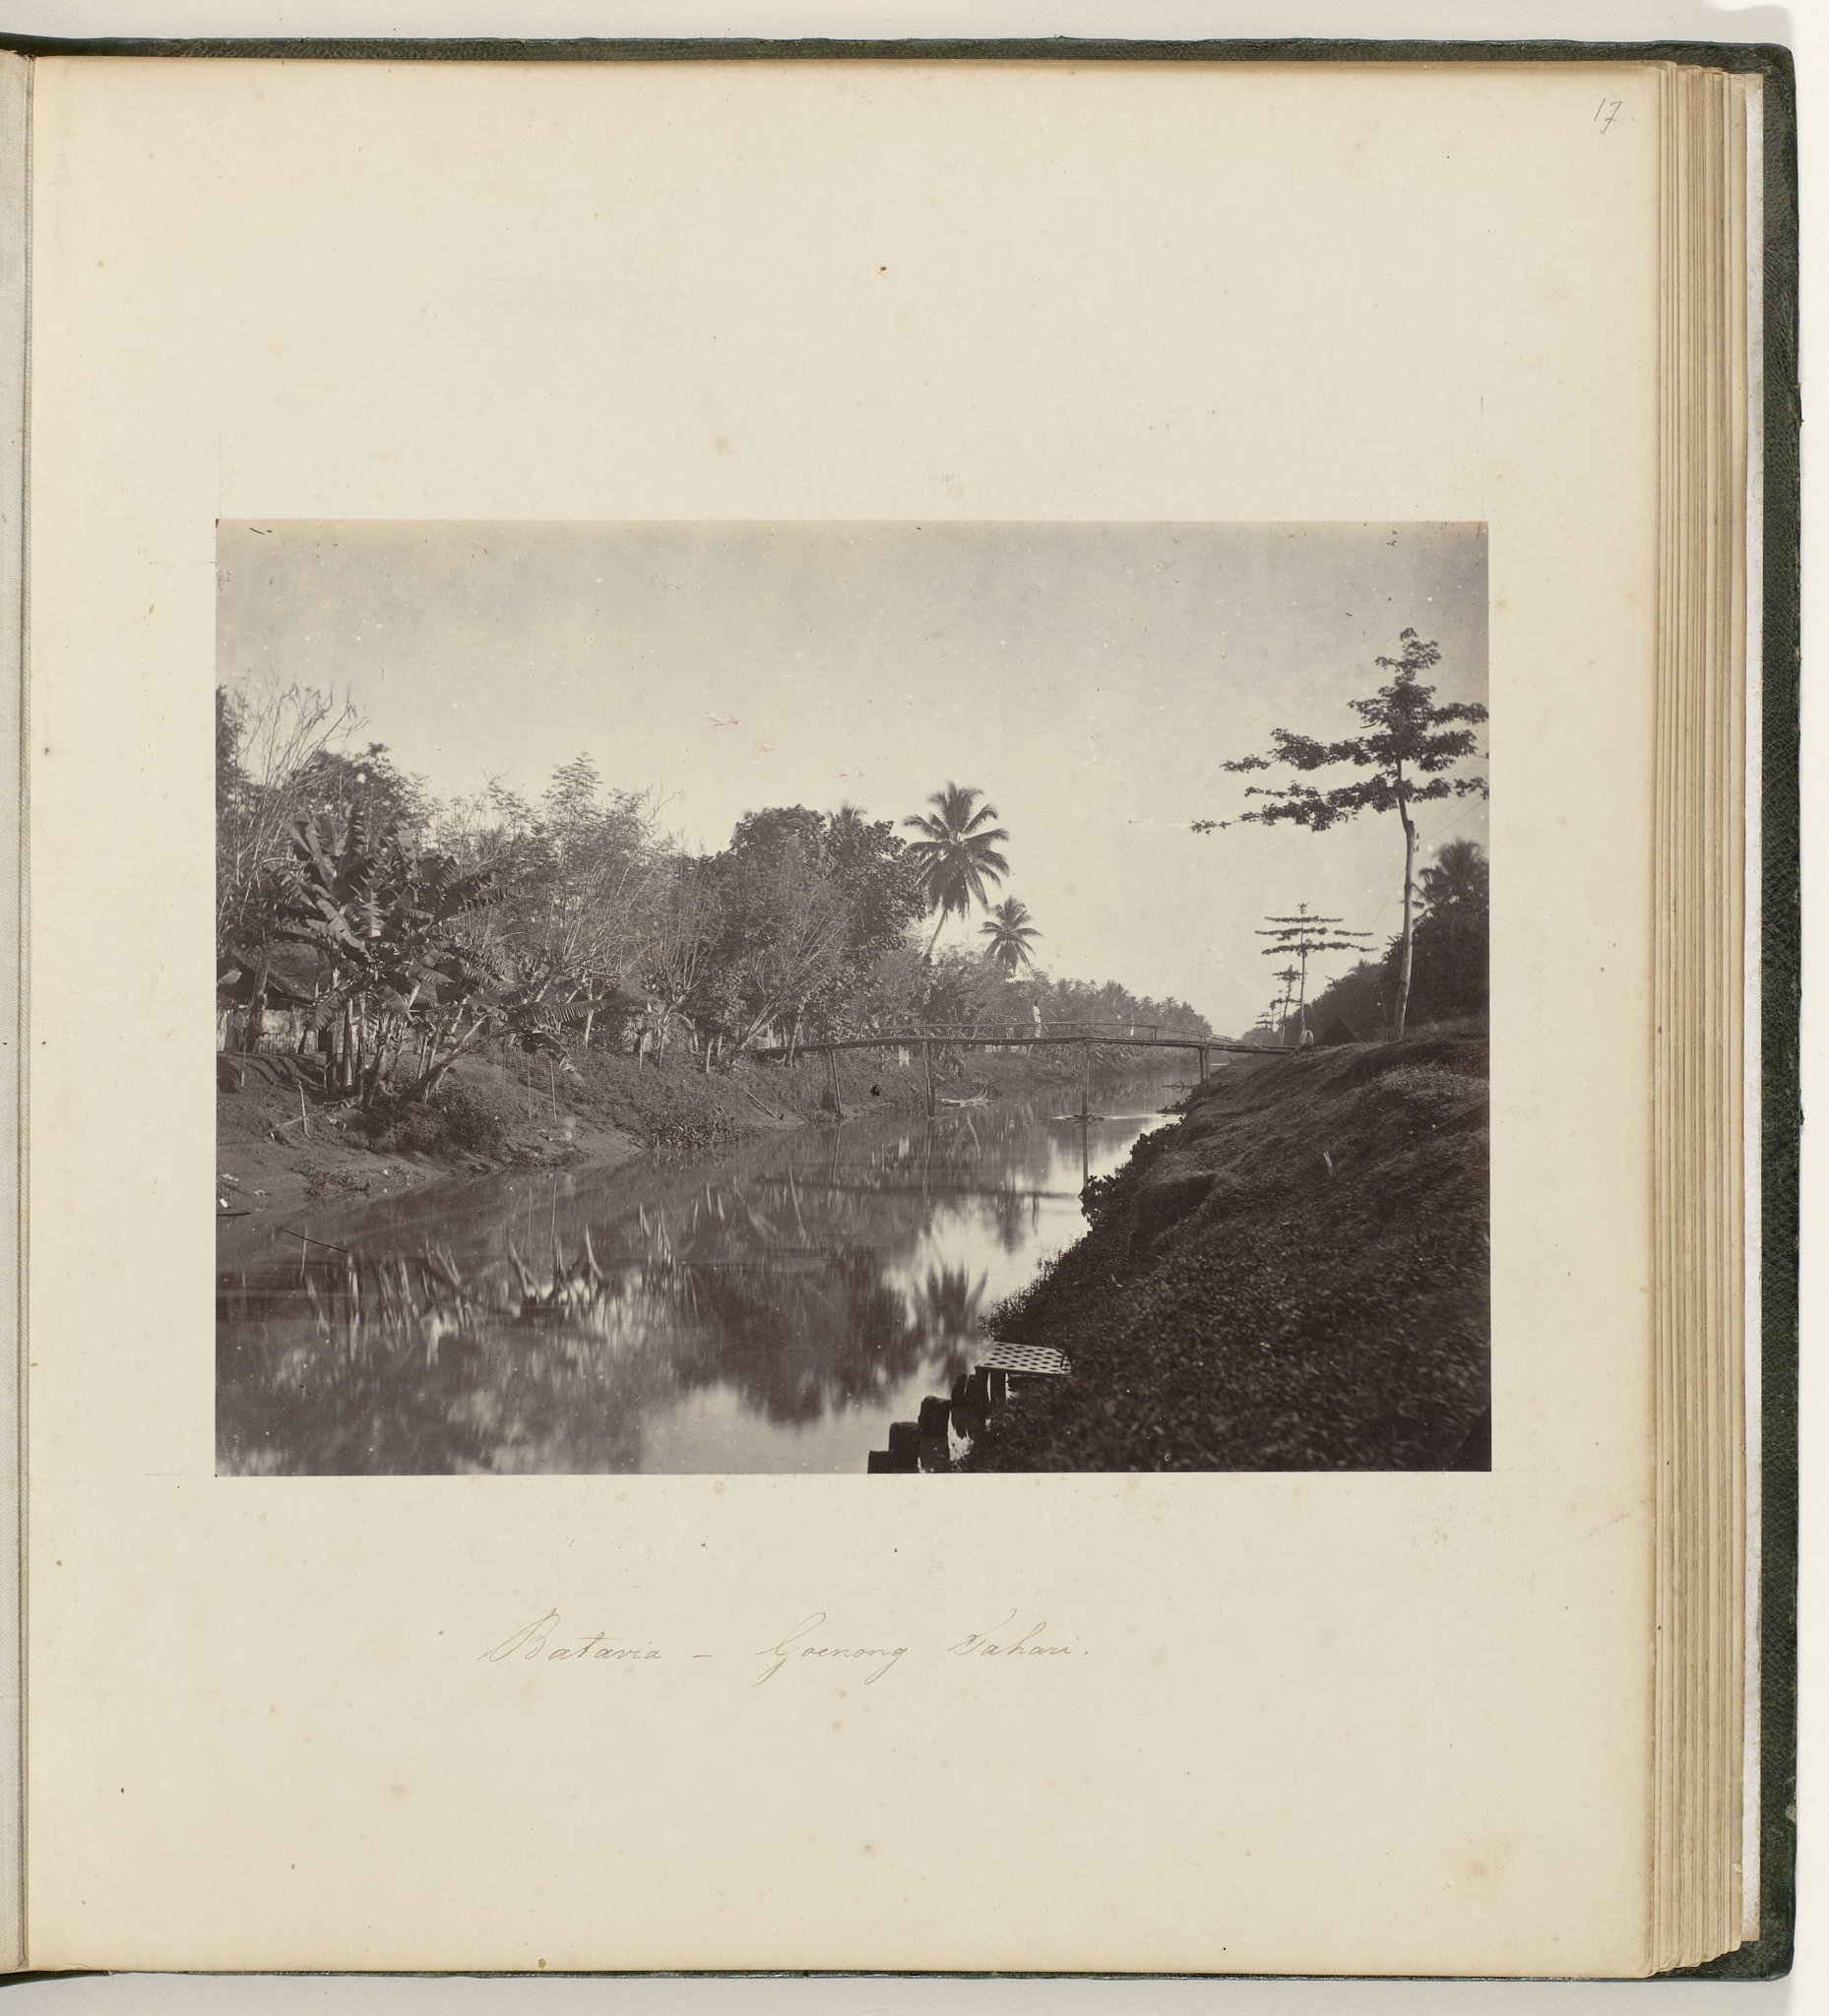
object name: photograph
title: Batavia - Goenong Sahari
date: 1863-1866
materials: photographic support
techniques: albumen print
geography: batavia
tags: canals, waters (in city), batavia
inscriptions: inscription: ‘Batavia - Goenong Sahari’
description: Gezicht op de kanaal Gunung Sahari, naar het noorden gezien, in Batavia. Onderdeel van het tweede groene fotoalbum met foto's van Java, uit het bezit van apotheker Specht-Grijp, die in 1865 vanuit Batavia naar Nederland terugkeerde.